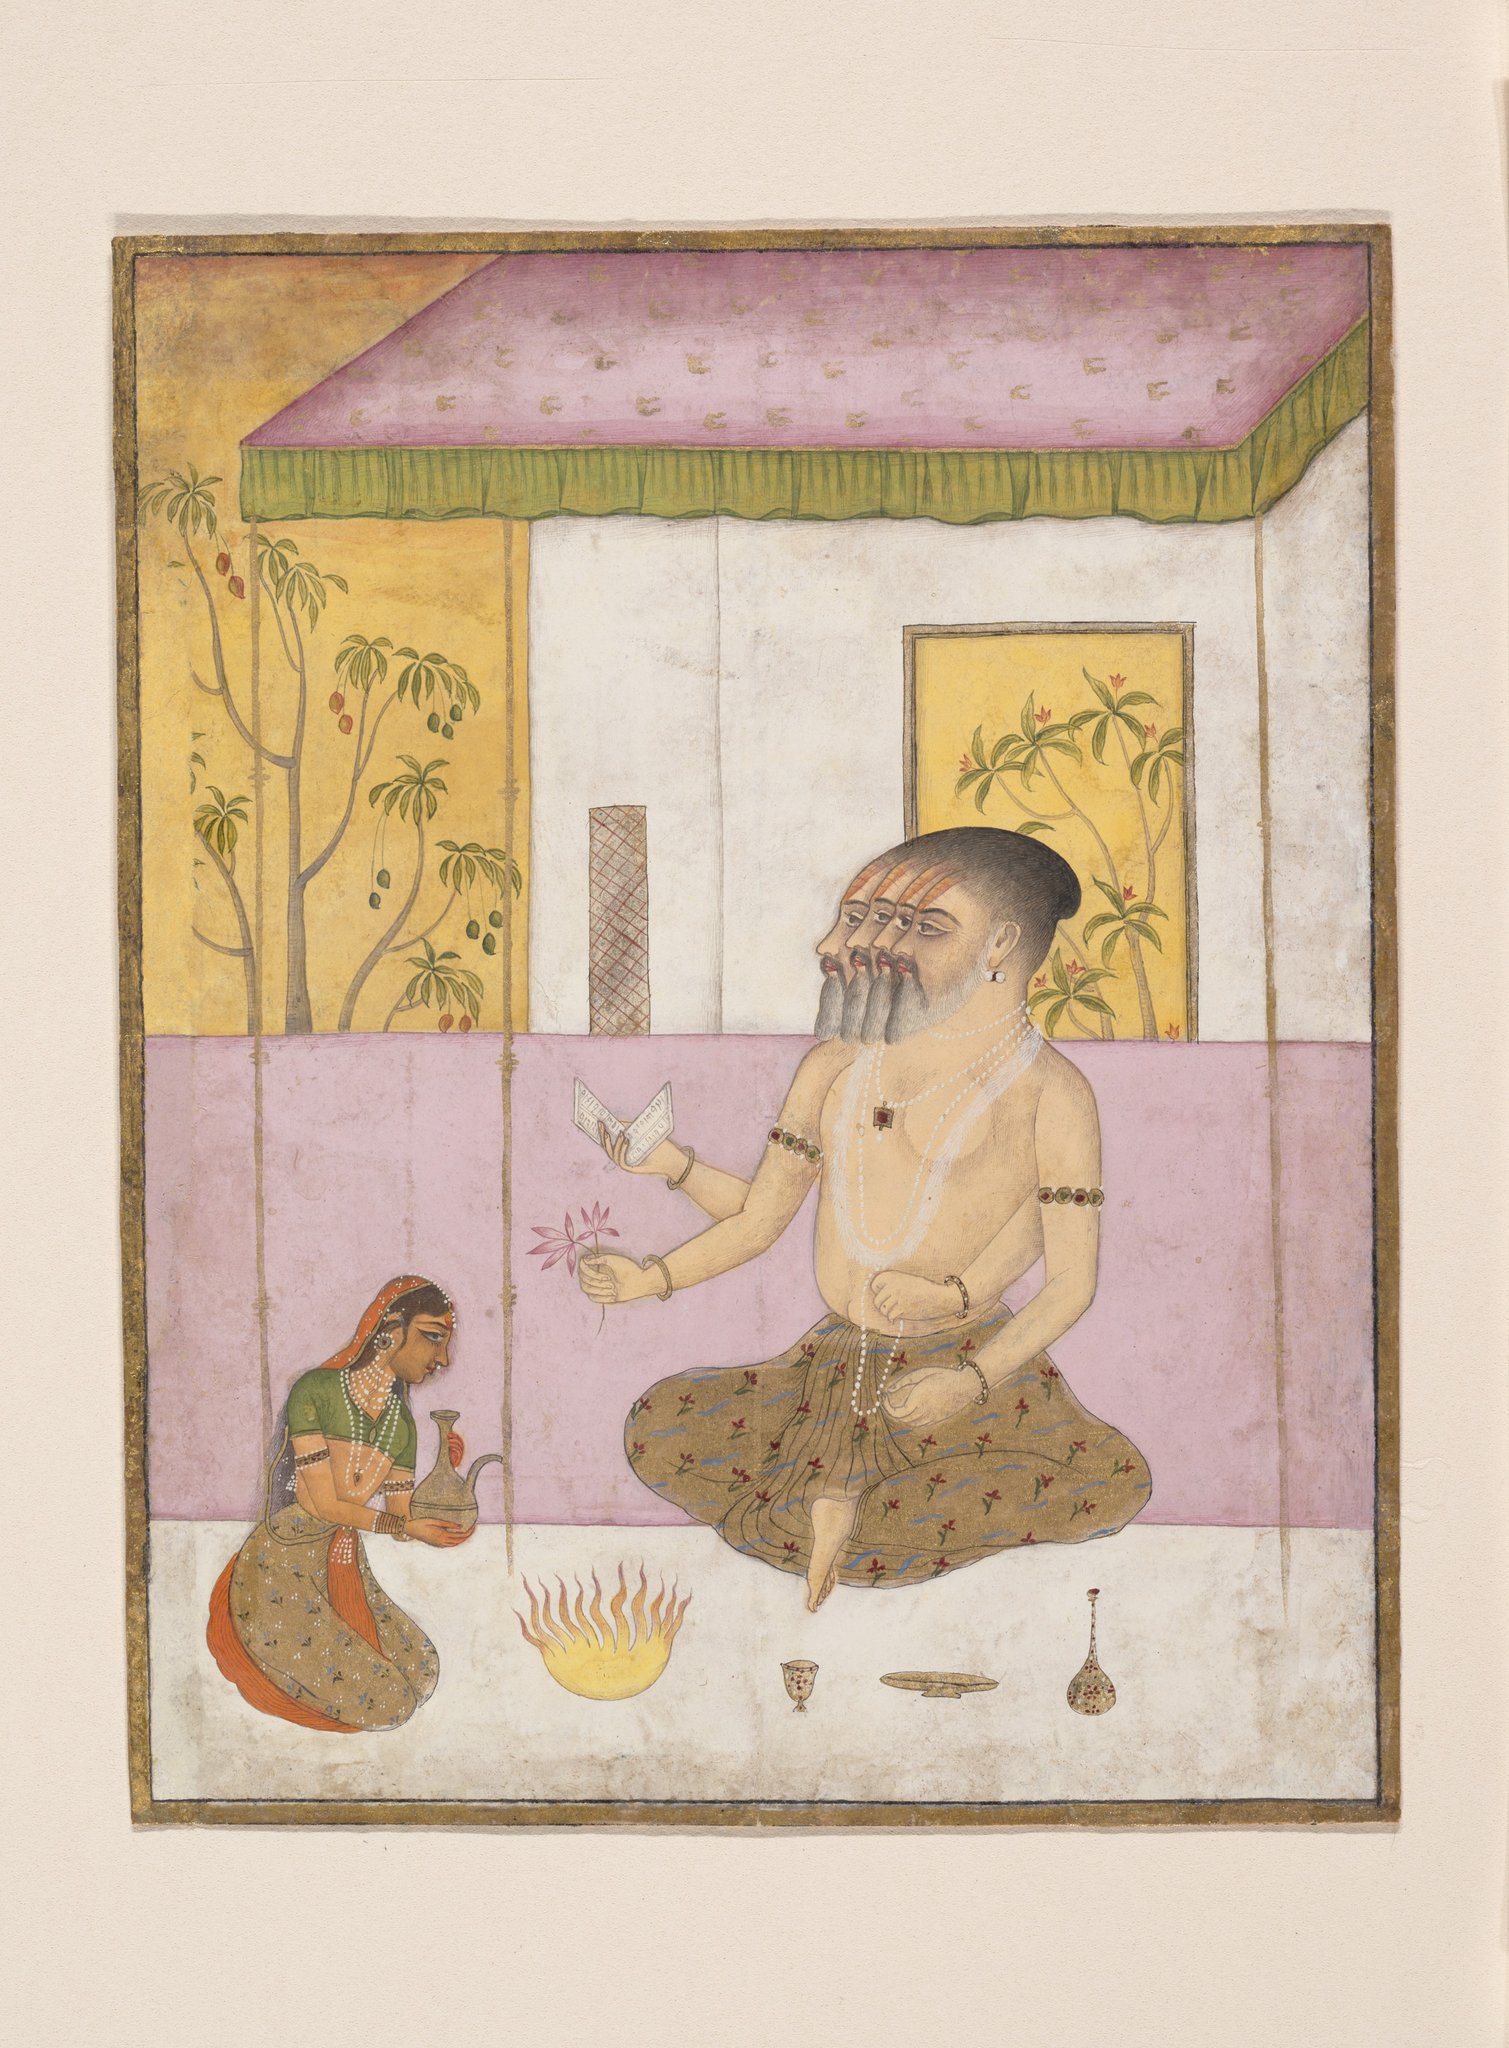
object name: folio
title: Khambhavati Ragini: Folio from a ragamala series (Garland of Musical Modes)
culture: indian, rajasthani, bikaner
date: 1675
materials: gold, ink, paper, watercolor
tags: women,fire,brahma